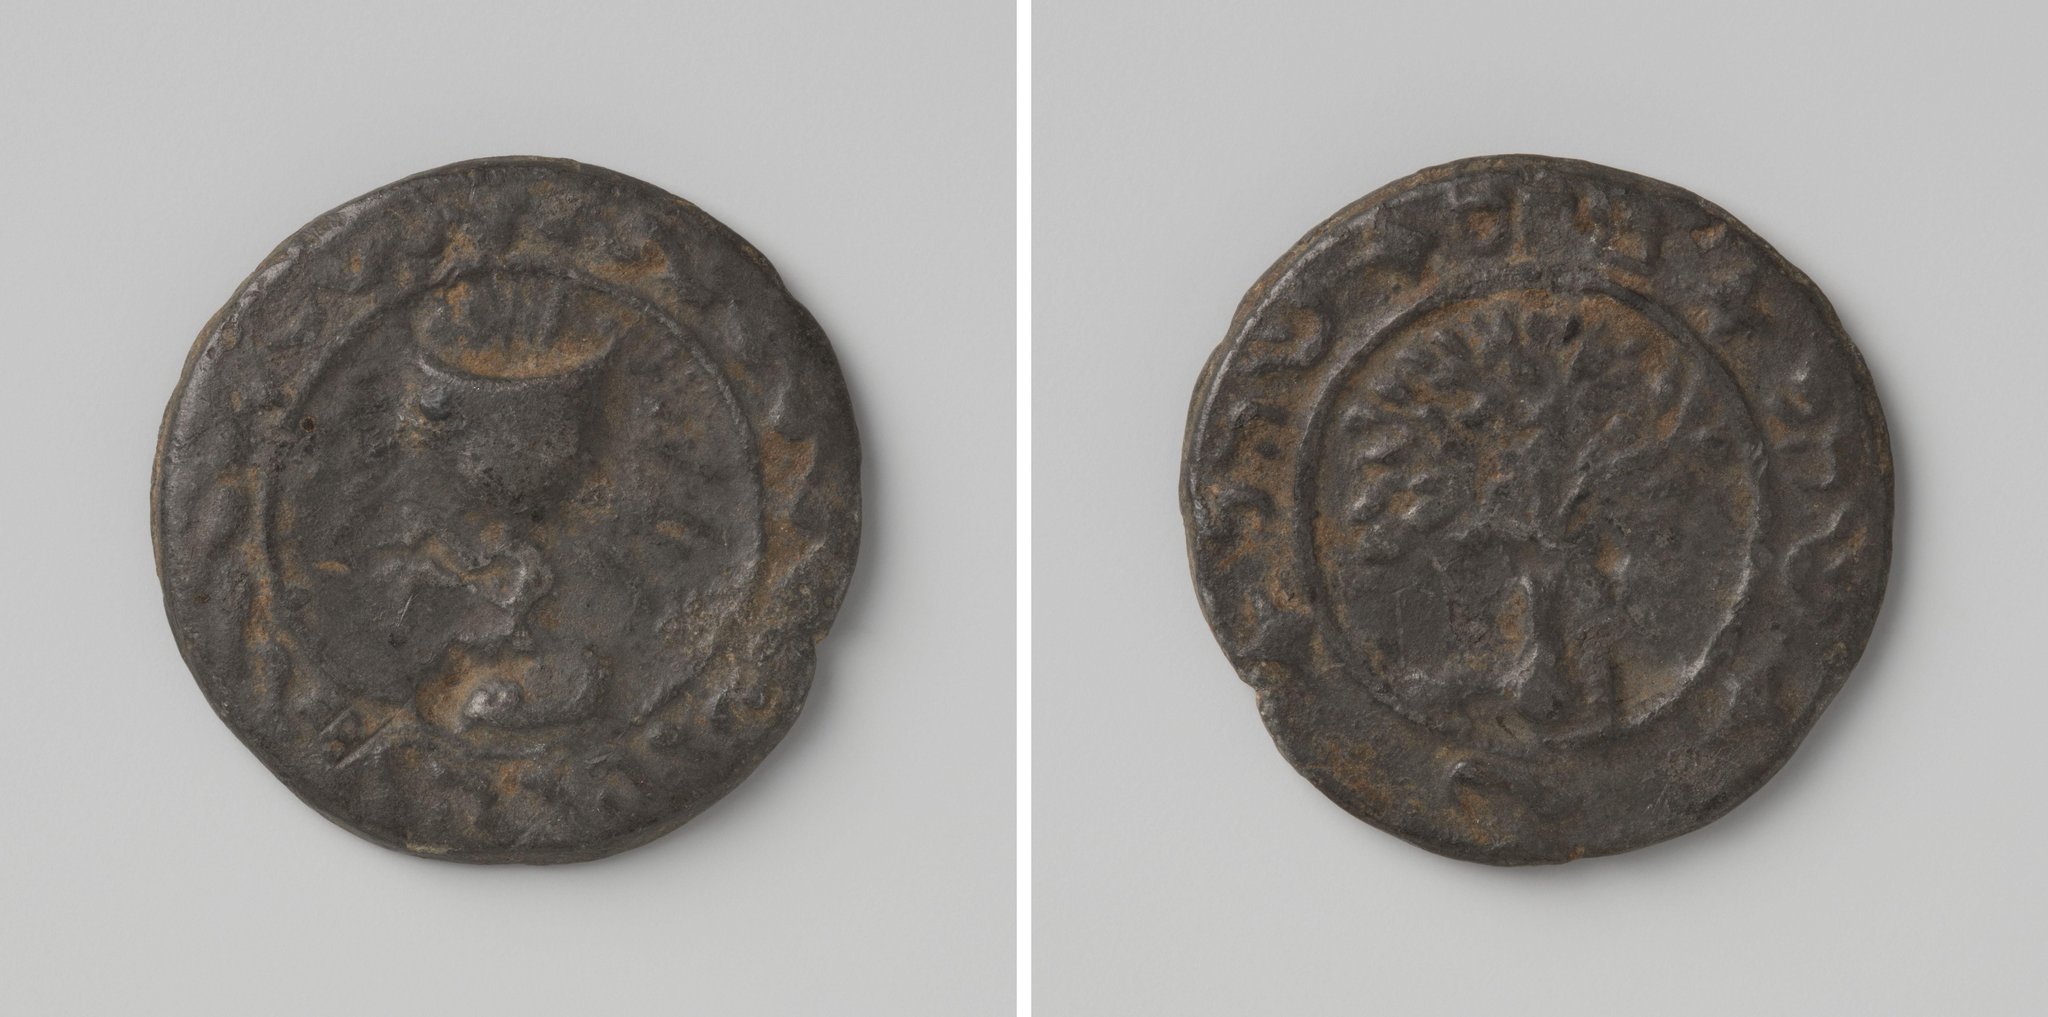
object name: devotional medal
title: Religieuze penning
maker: Anonymous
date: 1600-1800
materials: lead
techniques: casting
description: Loden penning. Voorzijde: stralende kelk binnen sierrand. Keerzijde: boom binnen omschrift [in Hebreeuws ?]. Vermoedelijk een religieuze penning.